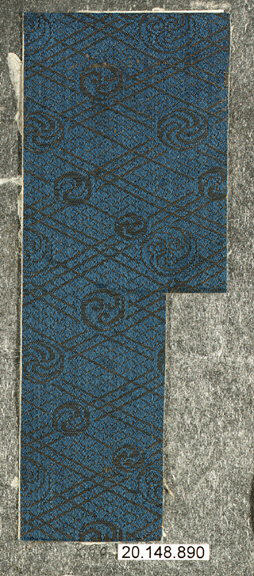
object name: piece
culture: chinese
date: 1701-1800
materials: silk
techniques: compound weave